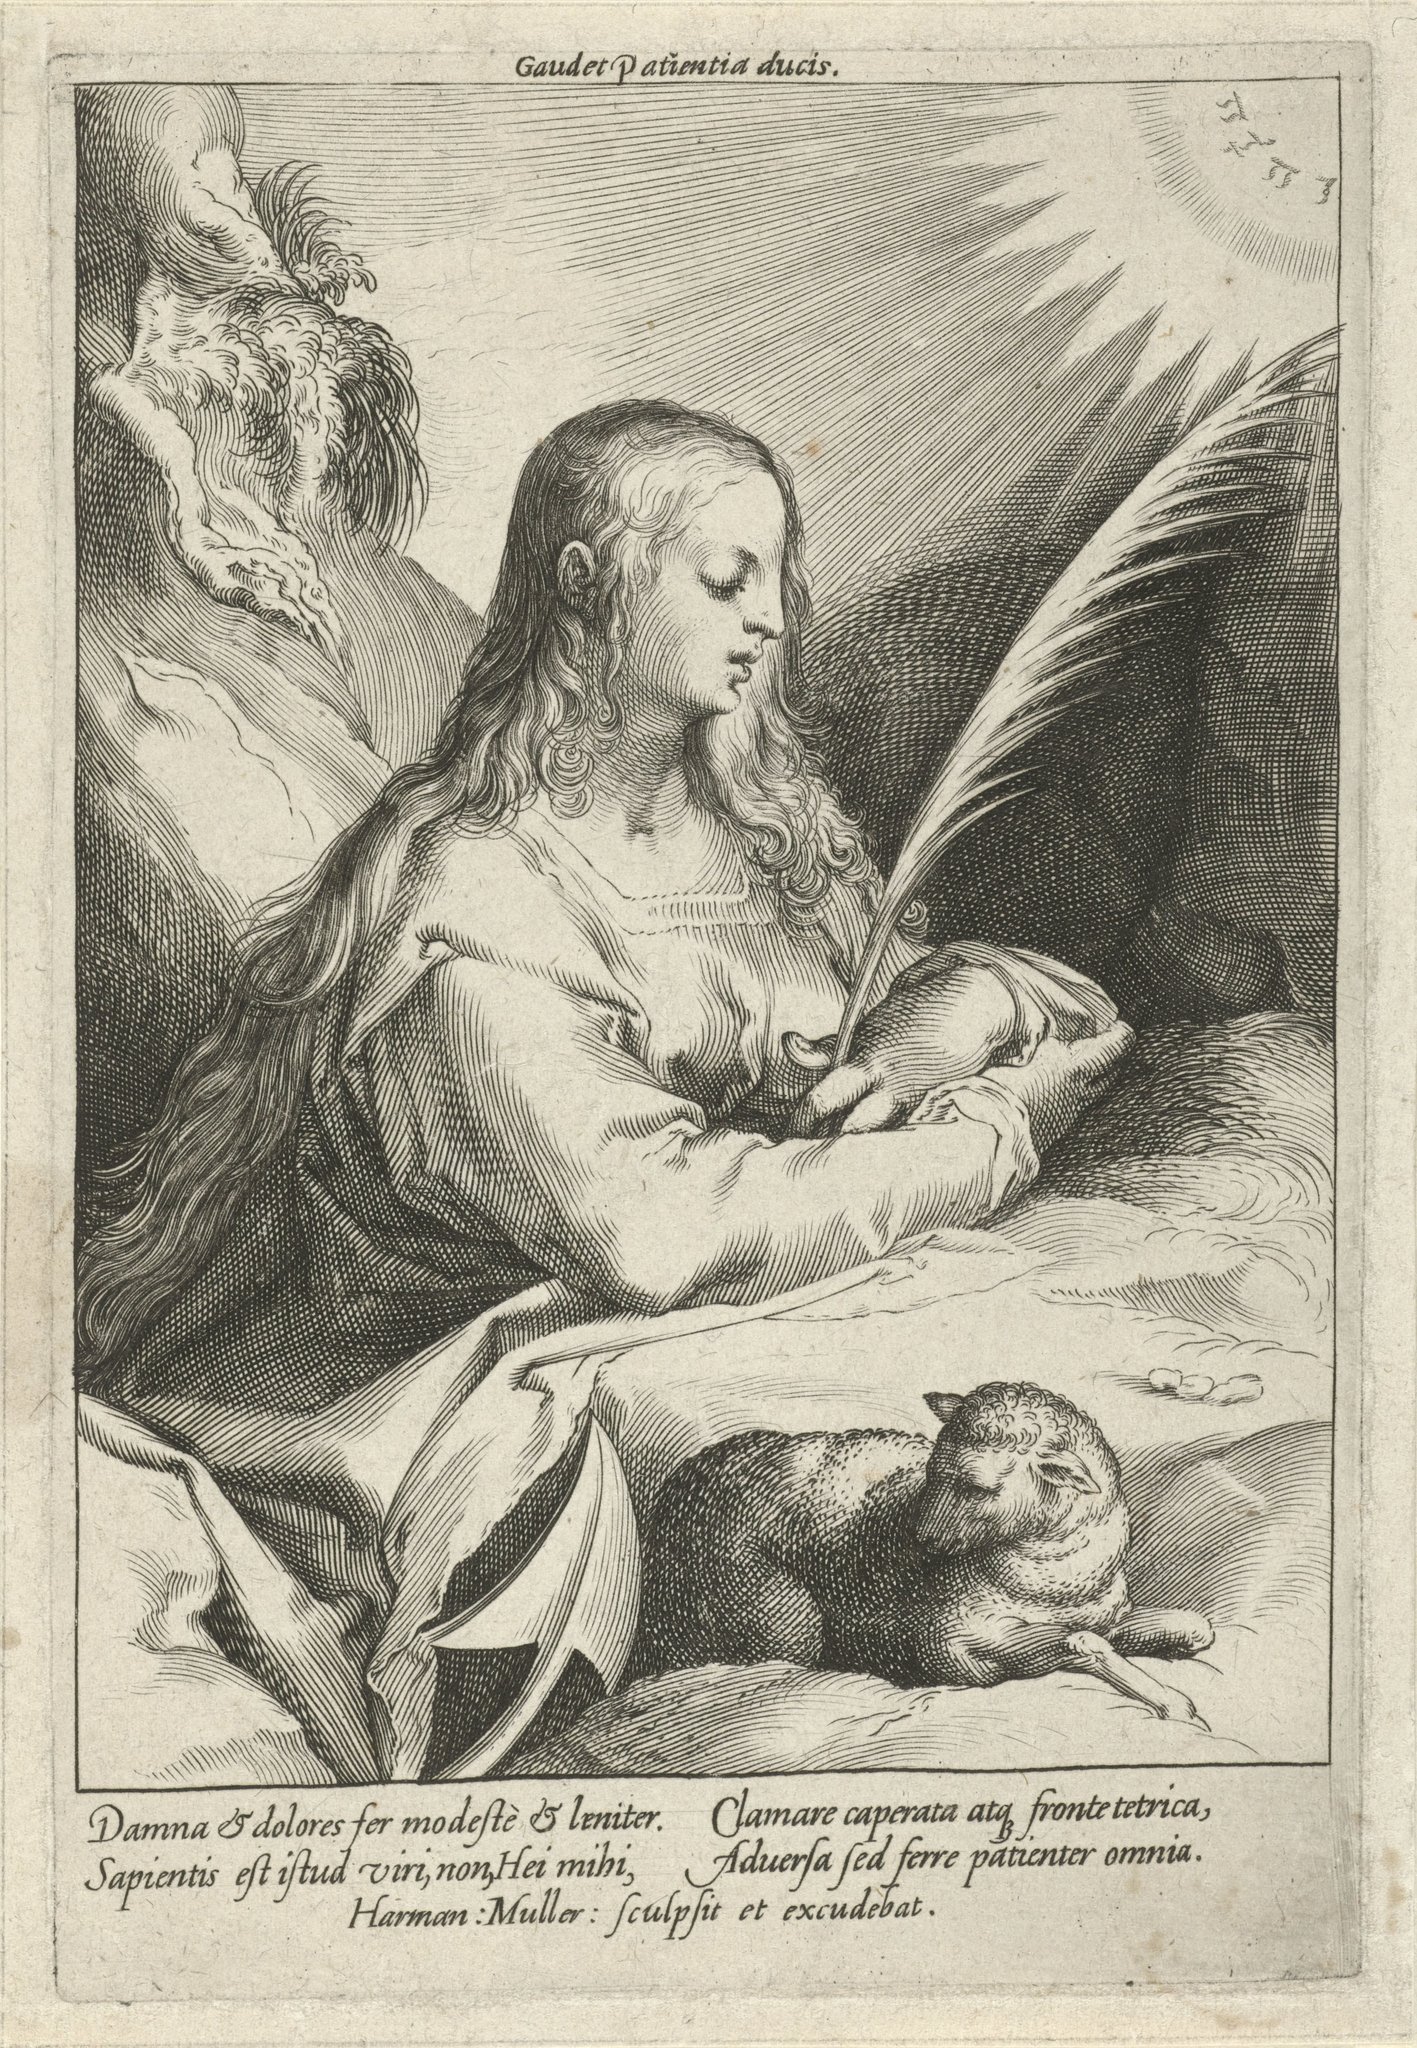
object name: print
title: H. Agnes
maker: harmen jansz muller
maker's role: print maker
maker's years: 1540-1617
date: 1590-1594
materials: paper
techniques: engraving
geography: amsterdam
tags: the virgin martyr agnes of rome; possible attributes: lamb, ring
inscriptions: collector's mark: Lugt 240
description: De heilige Agnes met een palmtak in haar hand en voor haar een lam. In de rechter bovenhoek de zon met het tetragram.